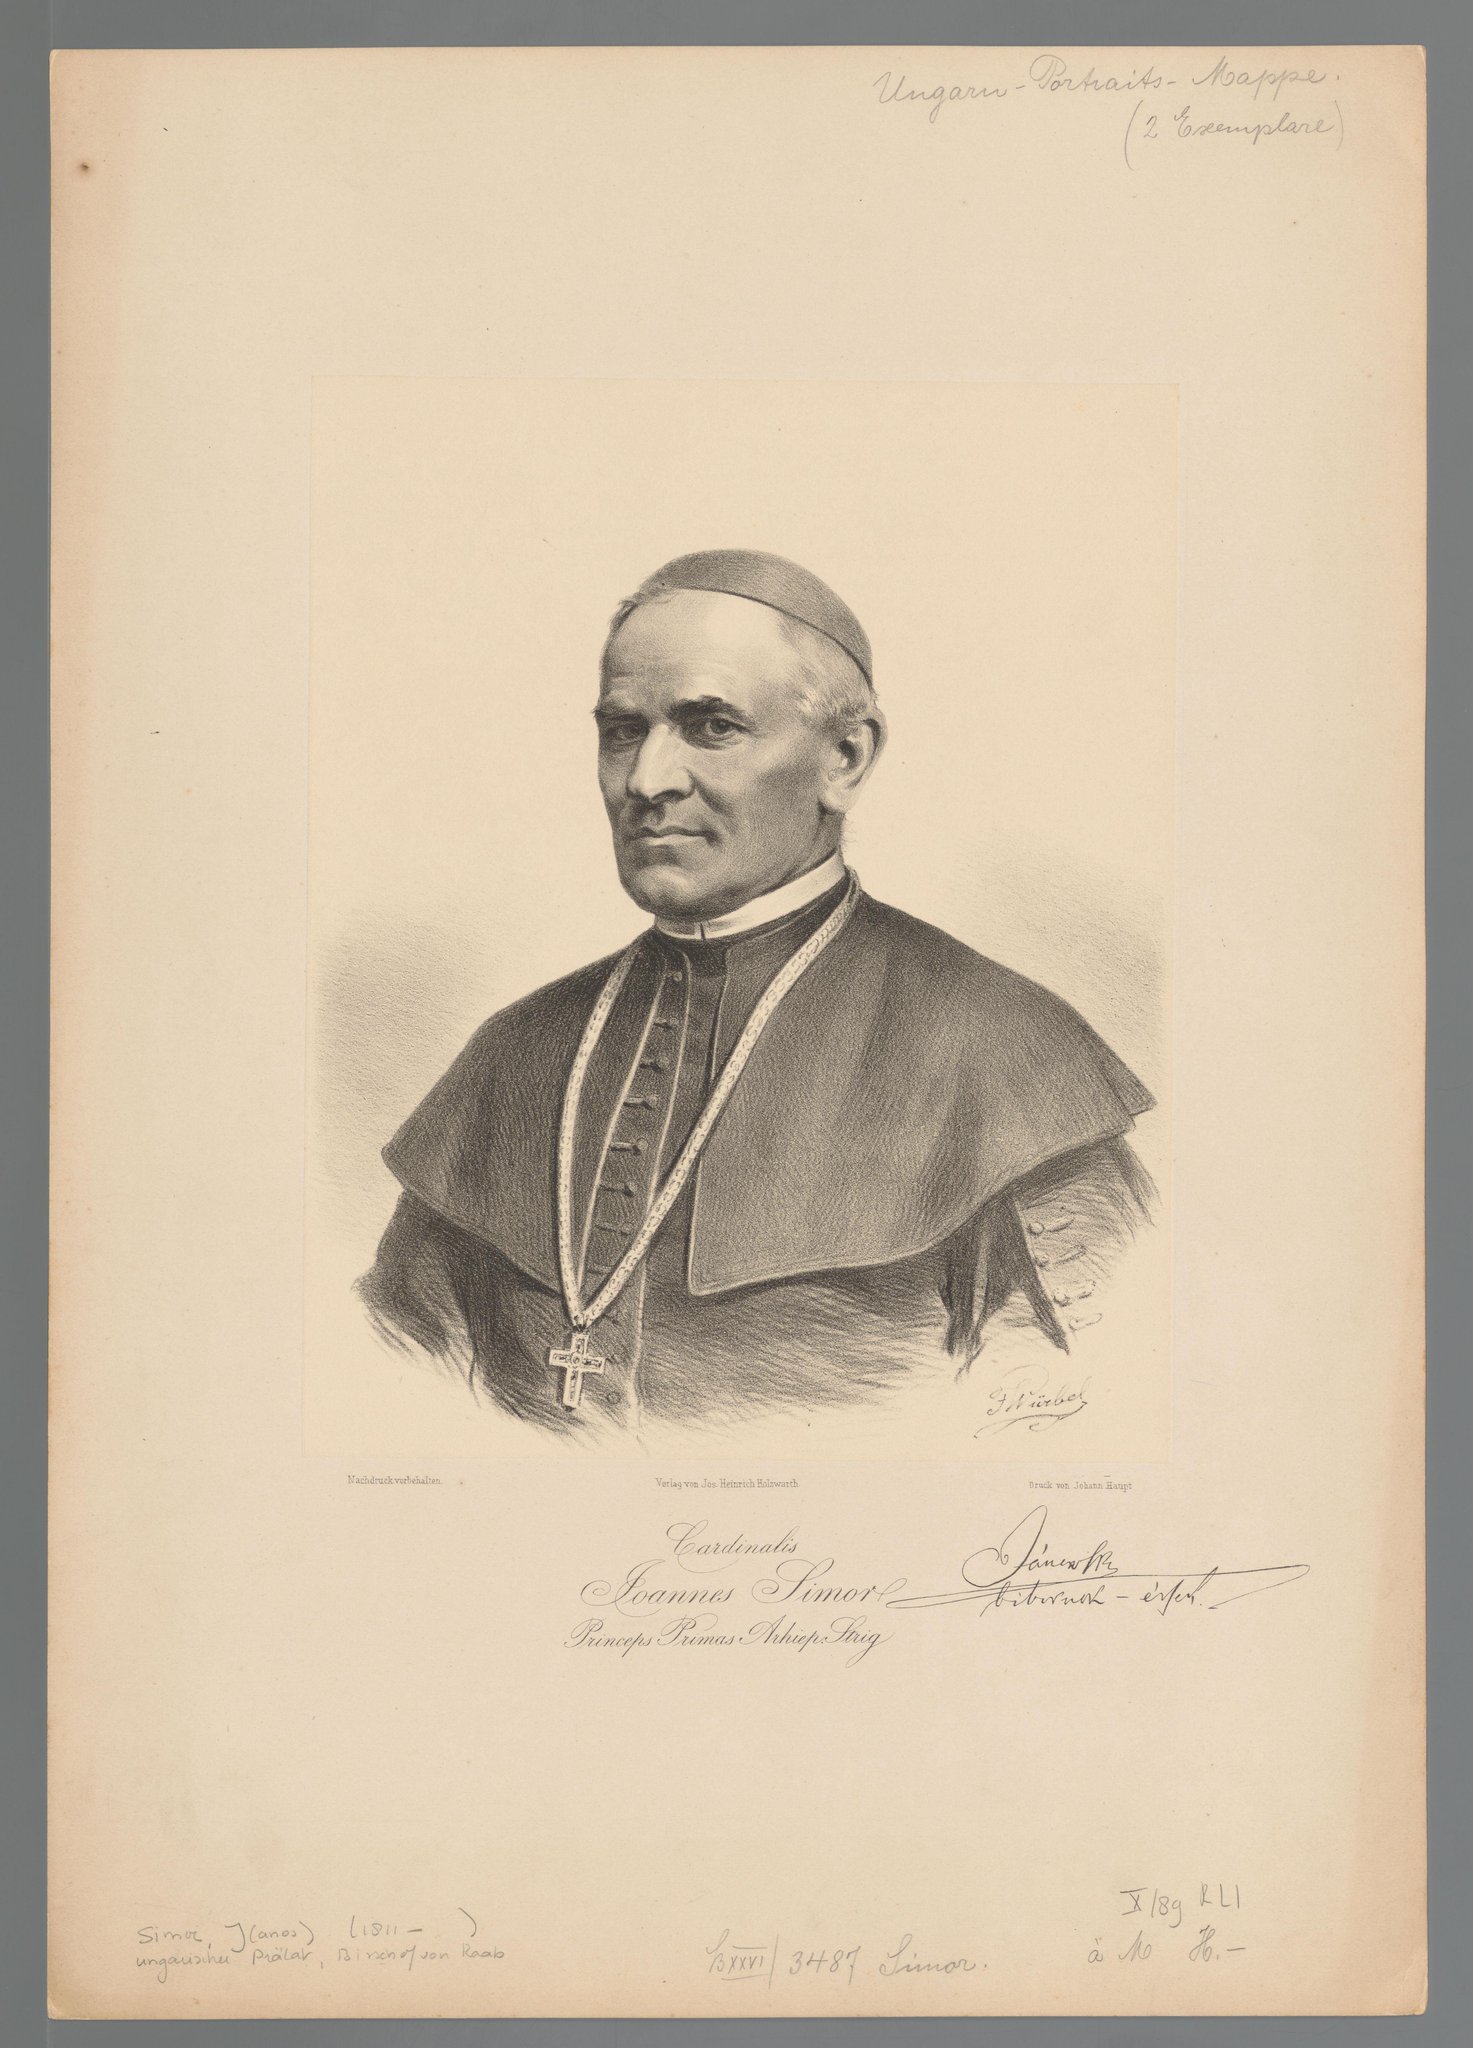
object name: print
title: Portret van János Simor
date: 1873-1900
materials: paper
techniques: lithograph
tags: cardinal, adult man, historical persons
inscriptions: inscription: ‘Ungaru-Portraits-Mappe/ (2 exemplare)/ LB XXVI 3487 Simor/ X/89 RLI/ à m H,-’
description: János Simor (1813-1891), bisschop van Raab. Buste naar links.